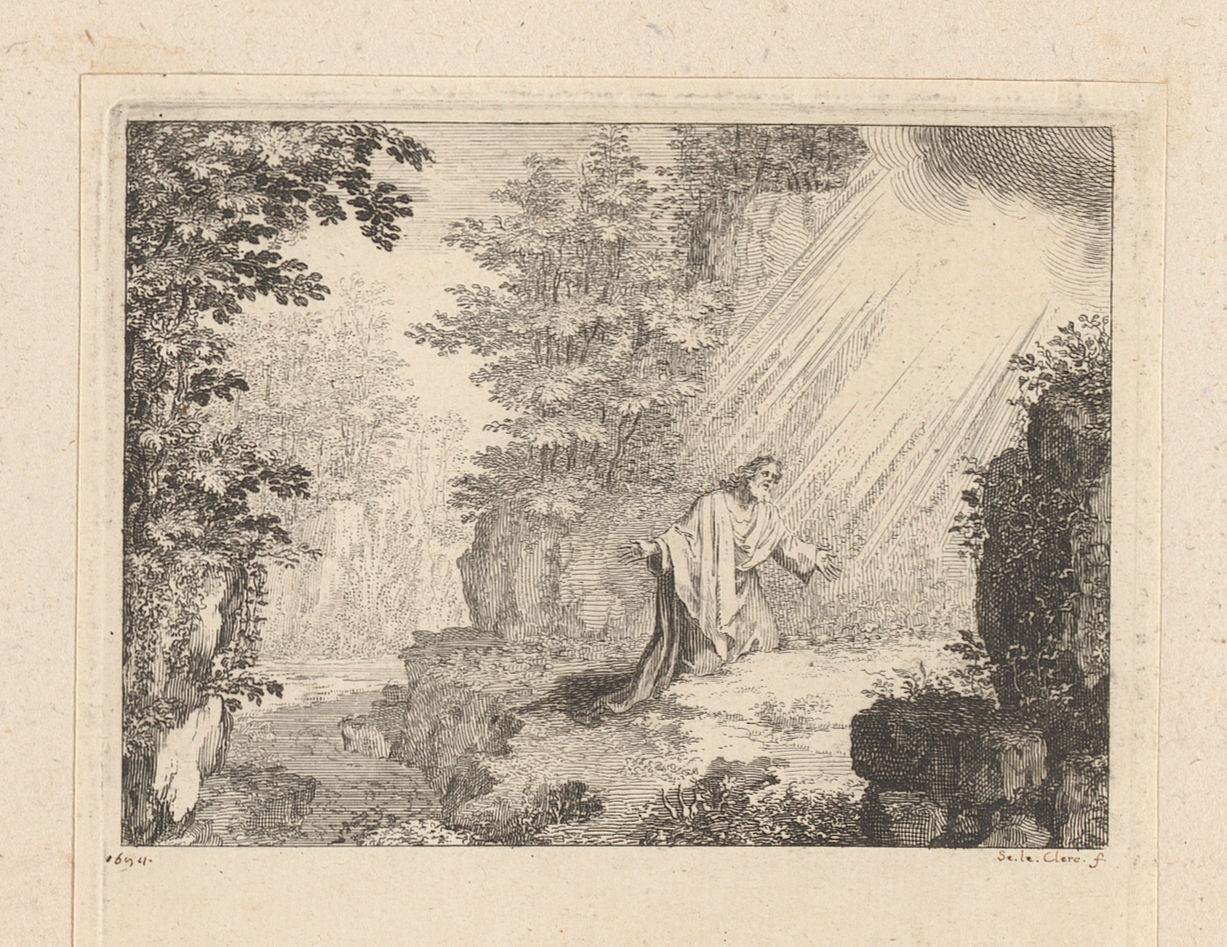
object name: print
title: Knielende H. Claudius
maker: sébastien leclerc (i)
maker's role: print maker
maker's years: 1637-1714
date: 1647-1714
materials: paper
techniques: etching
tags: saints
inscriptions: inscription: ‘1694 Se.le.Clerc.f’